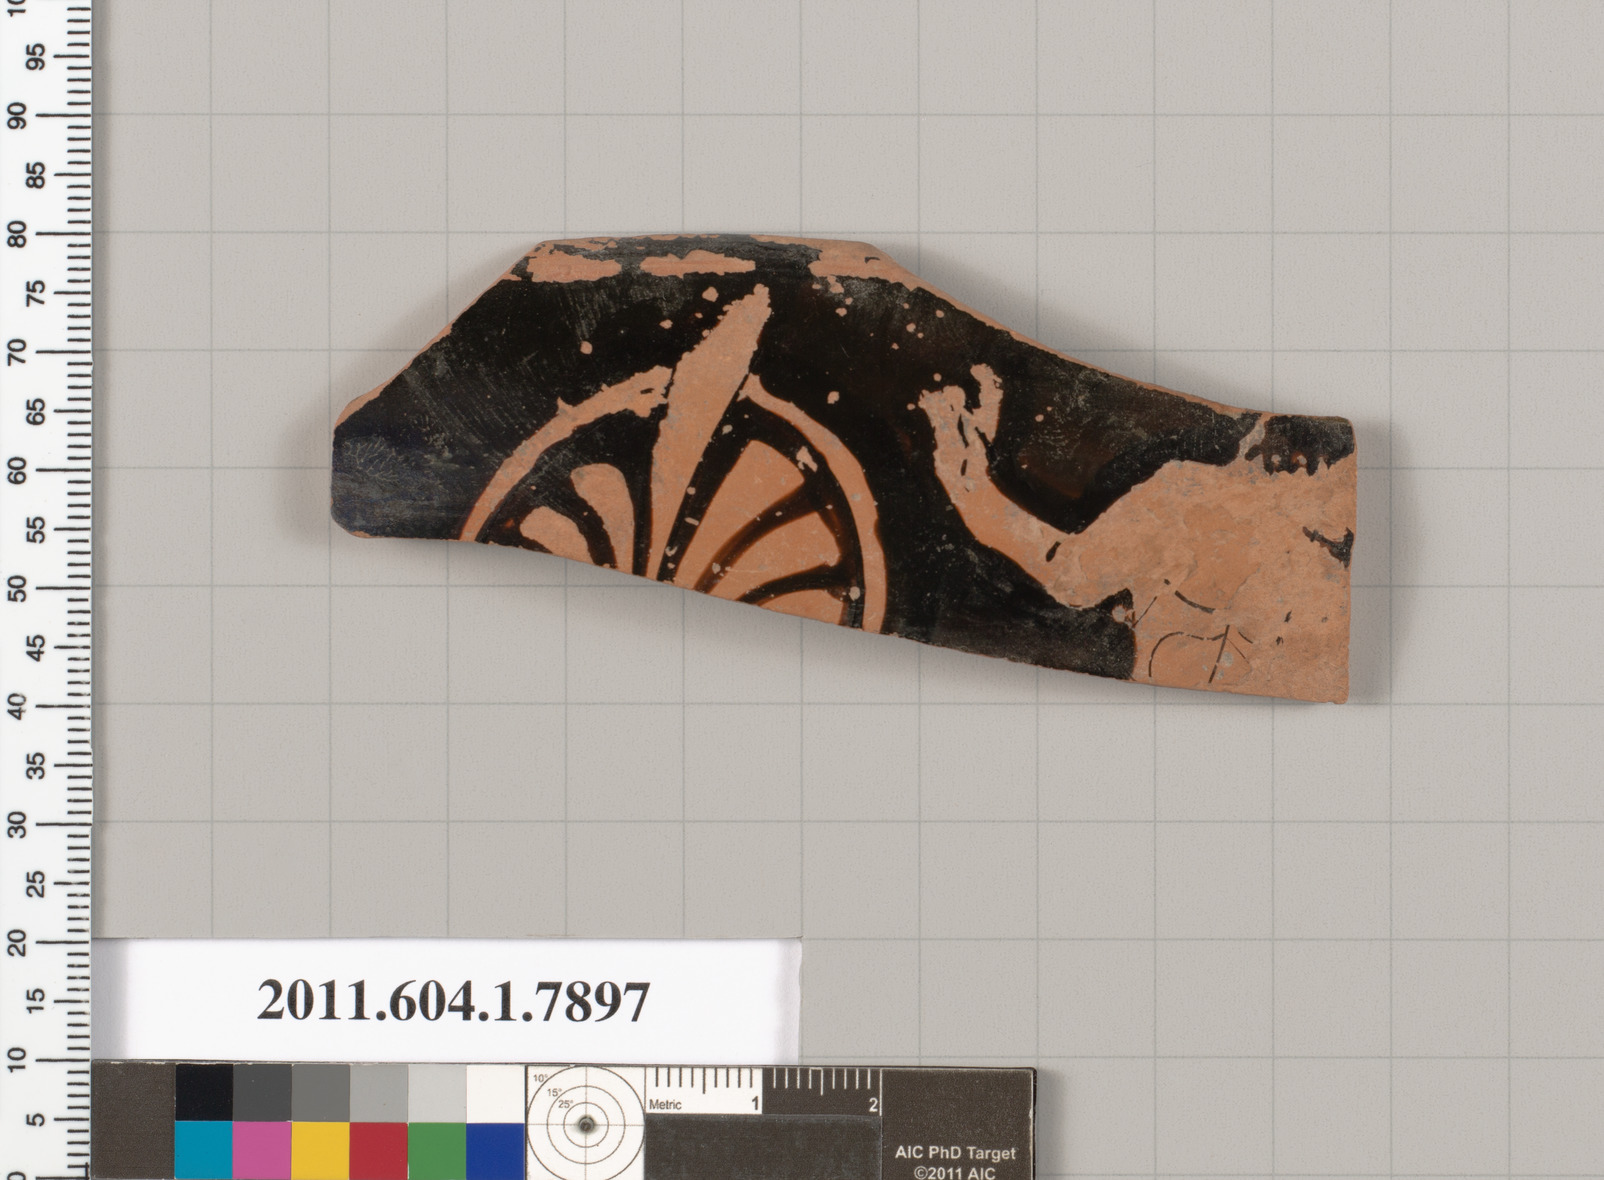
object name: kylix fragment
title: Terracotta rim fragment of a kylix (drinking cup)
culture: greek, attic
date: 450 BCE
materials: terracotta